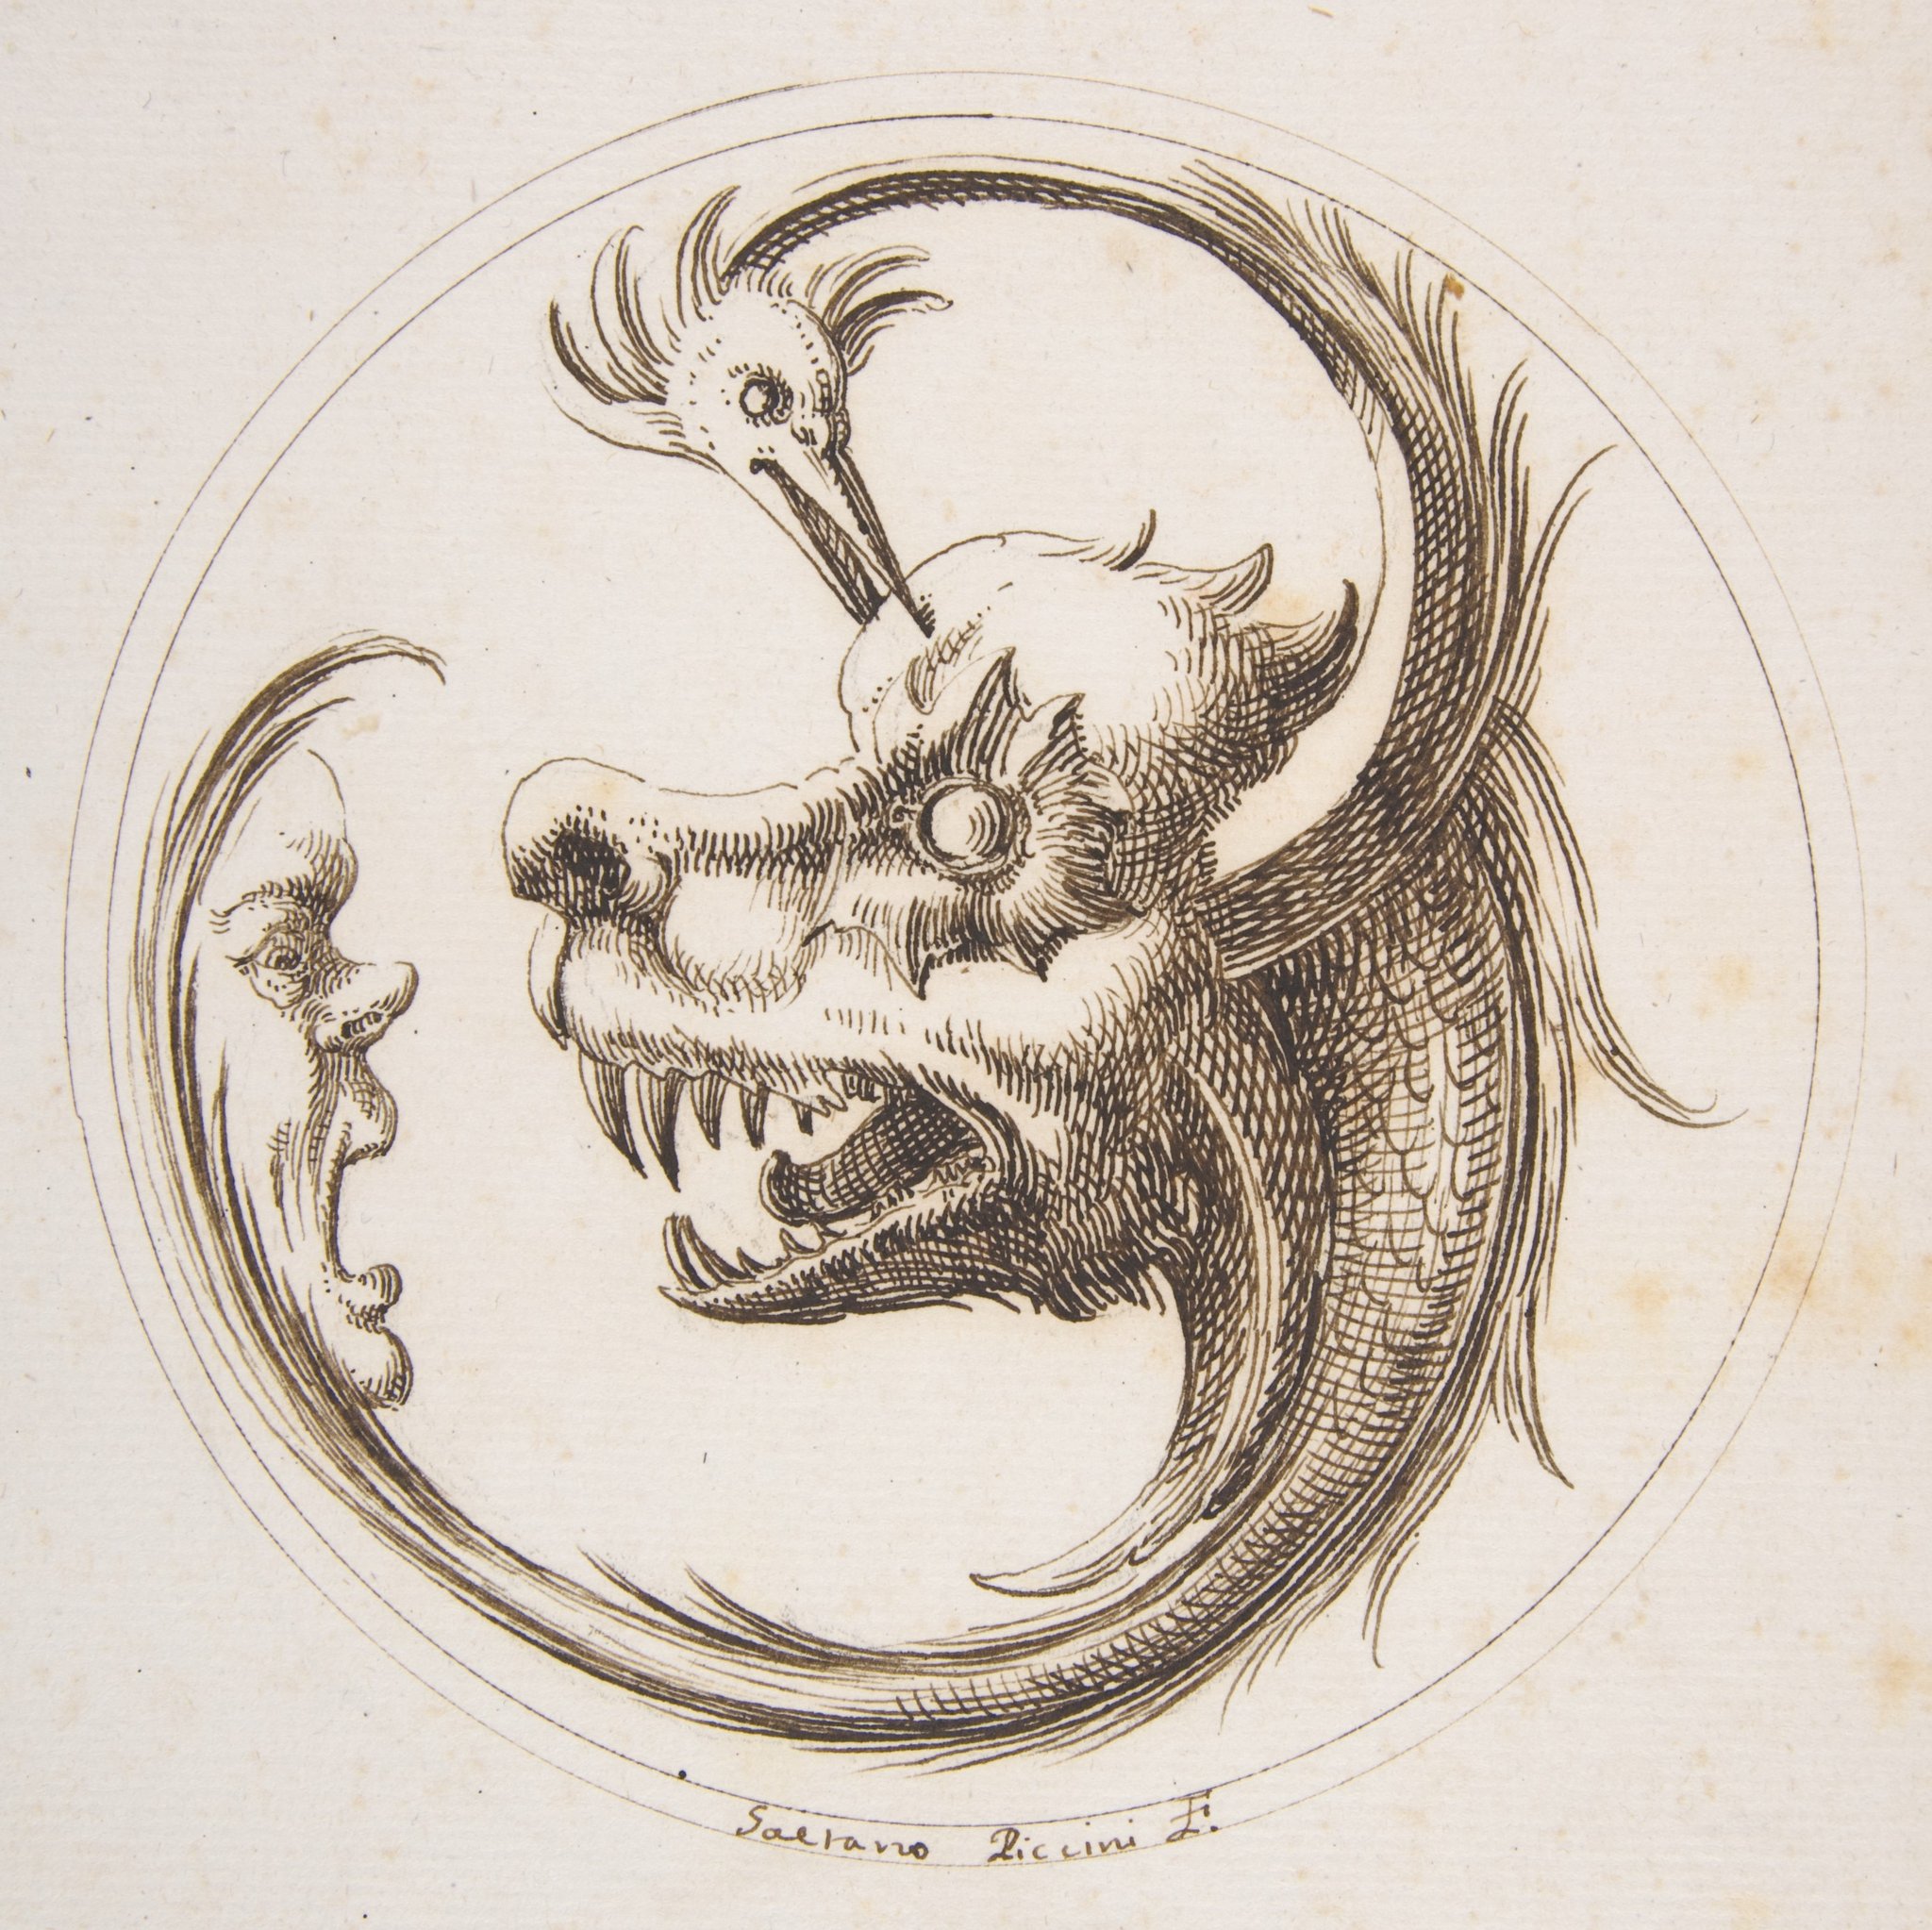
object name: drawing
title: Two Beasts and a Human Mask within a Circle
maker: gaetano piccini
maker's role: artist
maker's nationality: italian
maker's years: 1710-1730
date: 1727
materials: ink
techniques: pen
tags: animals,masks